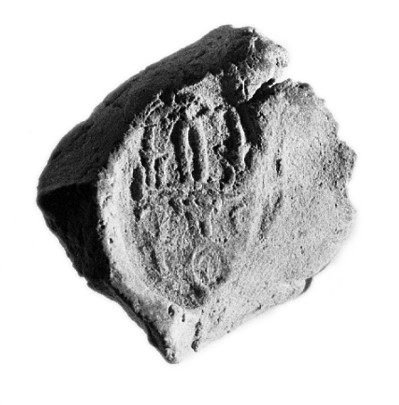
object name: sealing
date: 1981-1640 BCE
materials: mud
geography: egypt